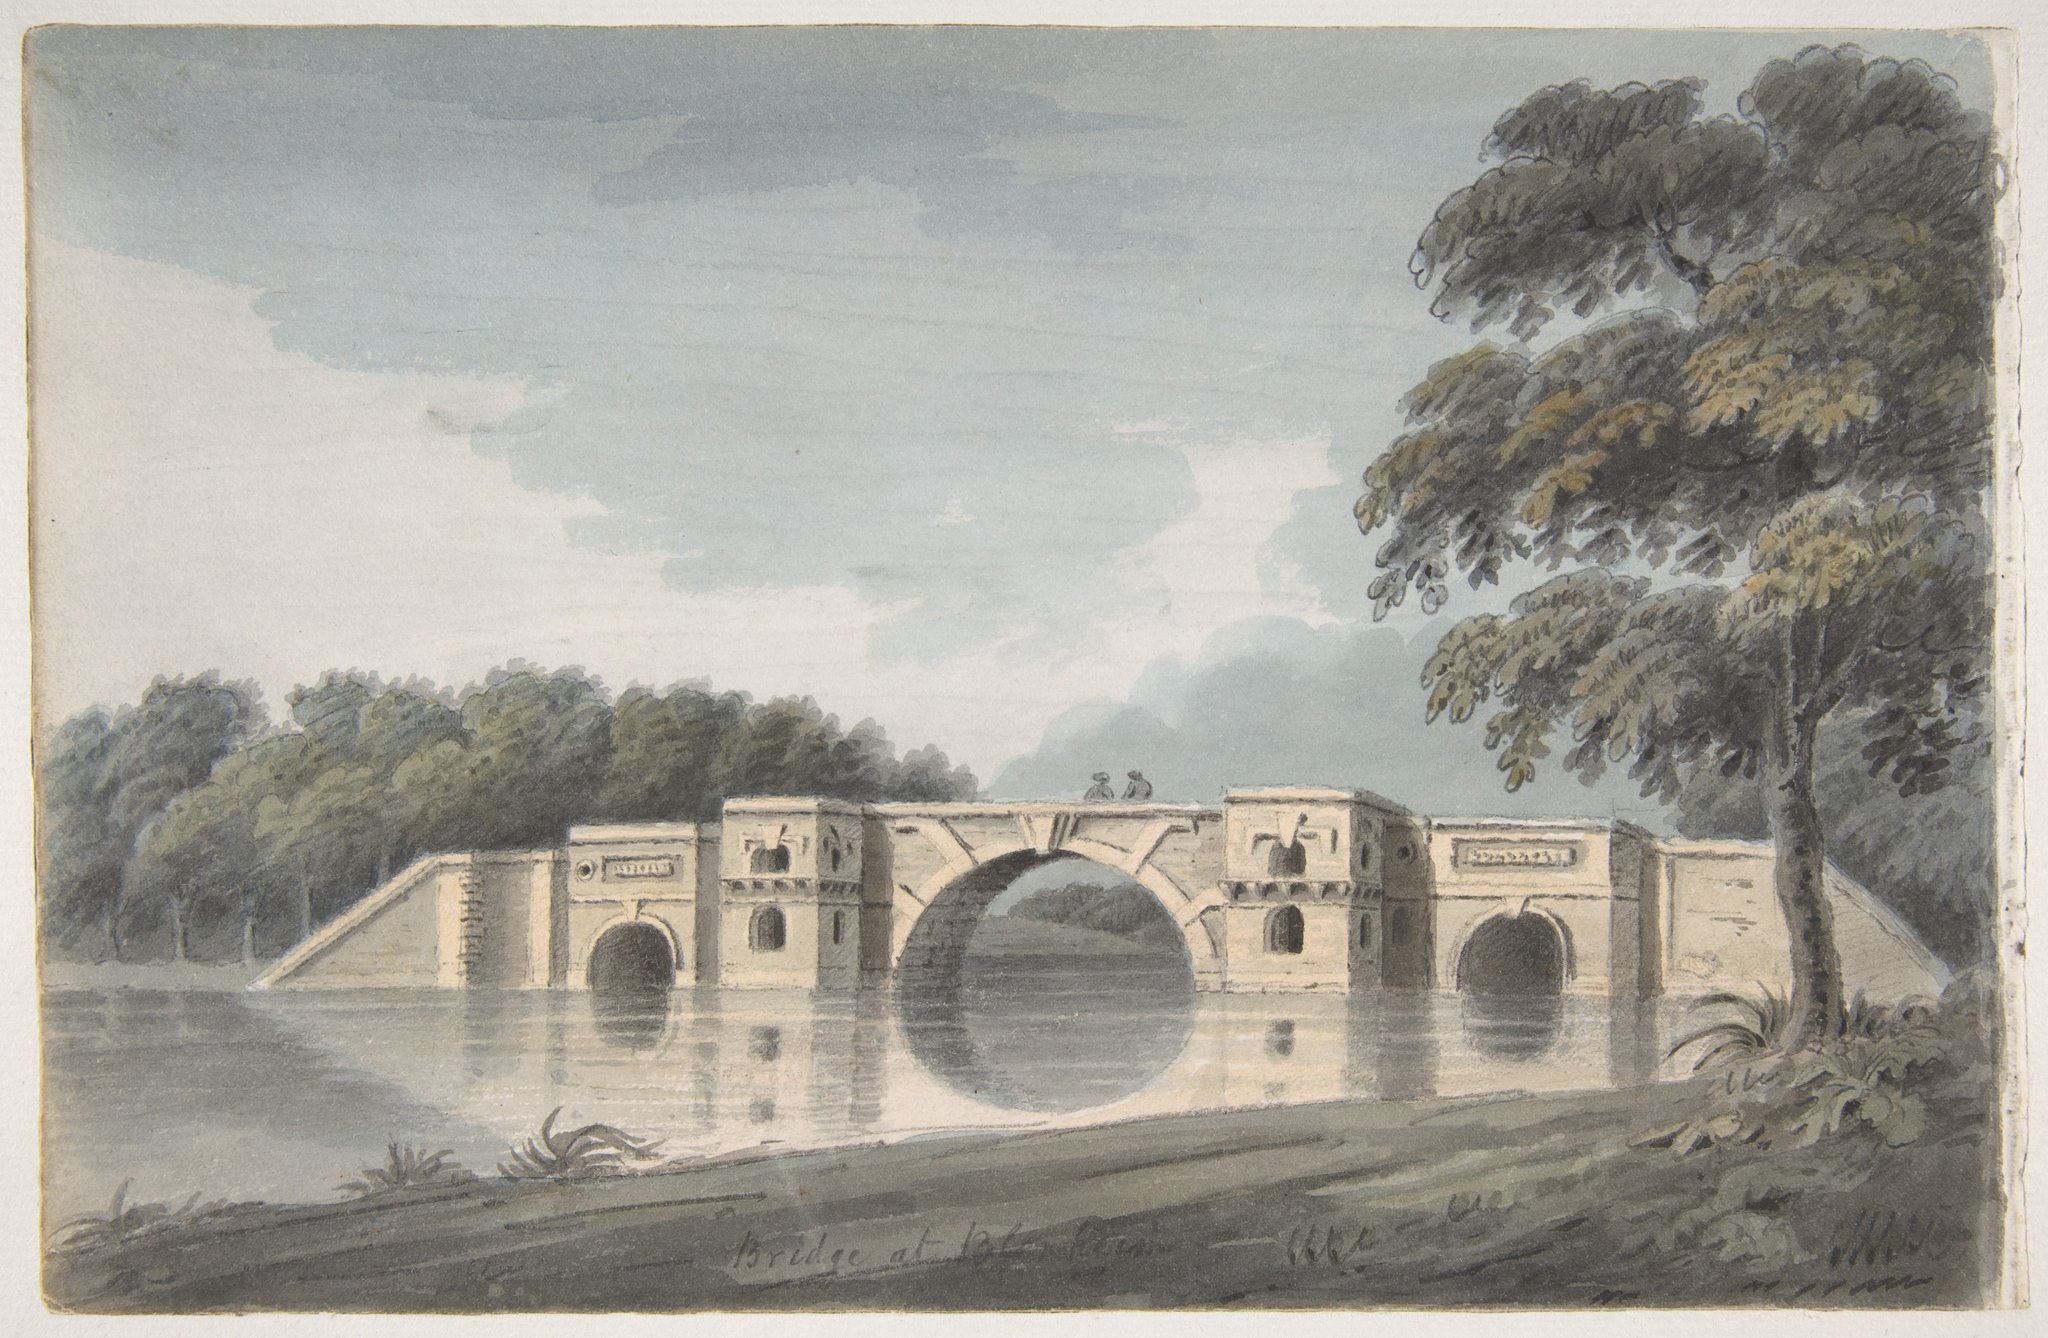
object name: drawing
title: Bridge at Blenheim Palace (recto); York Cathedral (verso)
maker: hubert cornish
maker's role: artist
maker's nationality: british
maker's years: 1757-1832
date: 1780-1832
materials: gouache, graphite, watercolor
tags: bridges,cathedrals